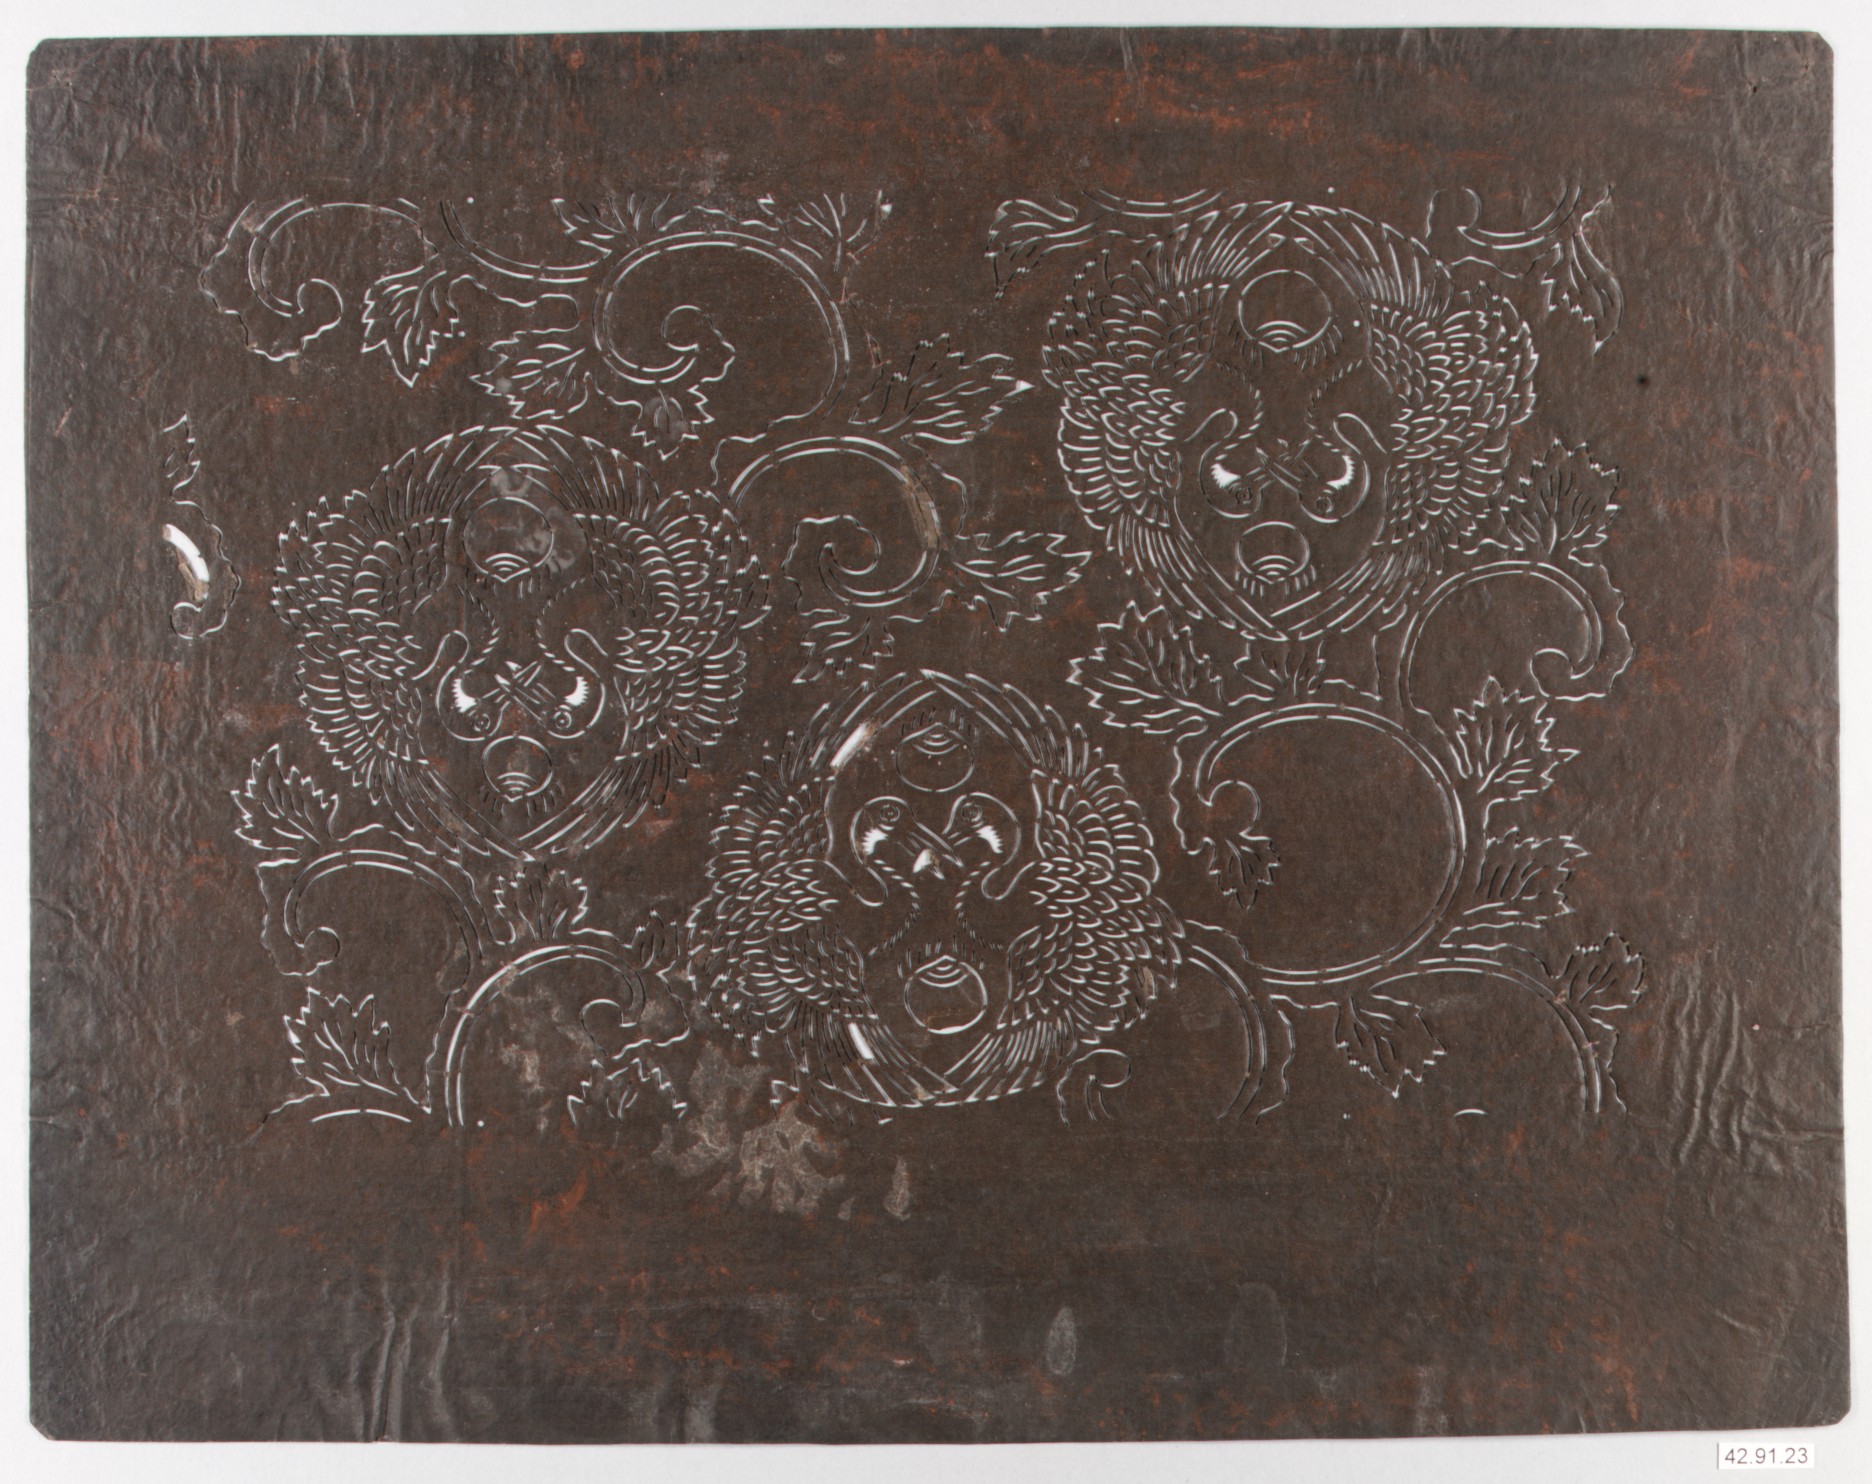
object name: stencil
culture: japanese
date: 1801-1900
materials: paper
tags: cranes